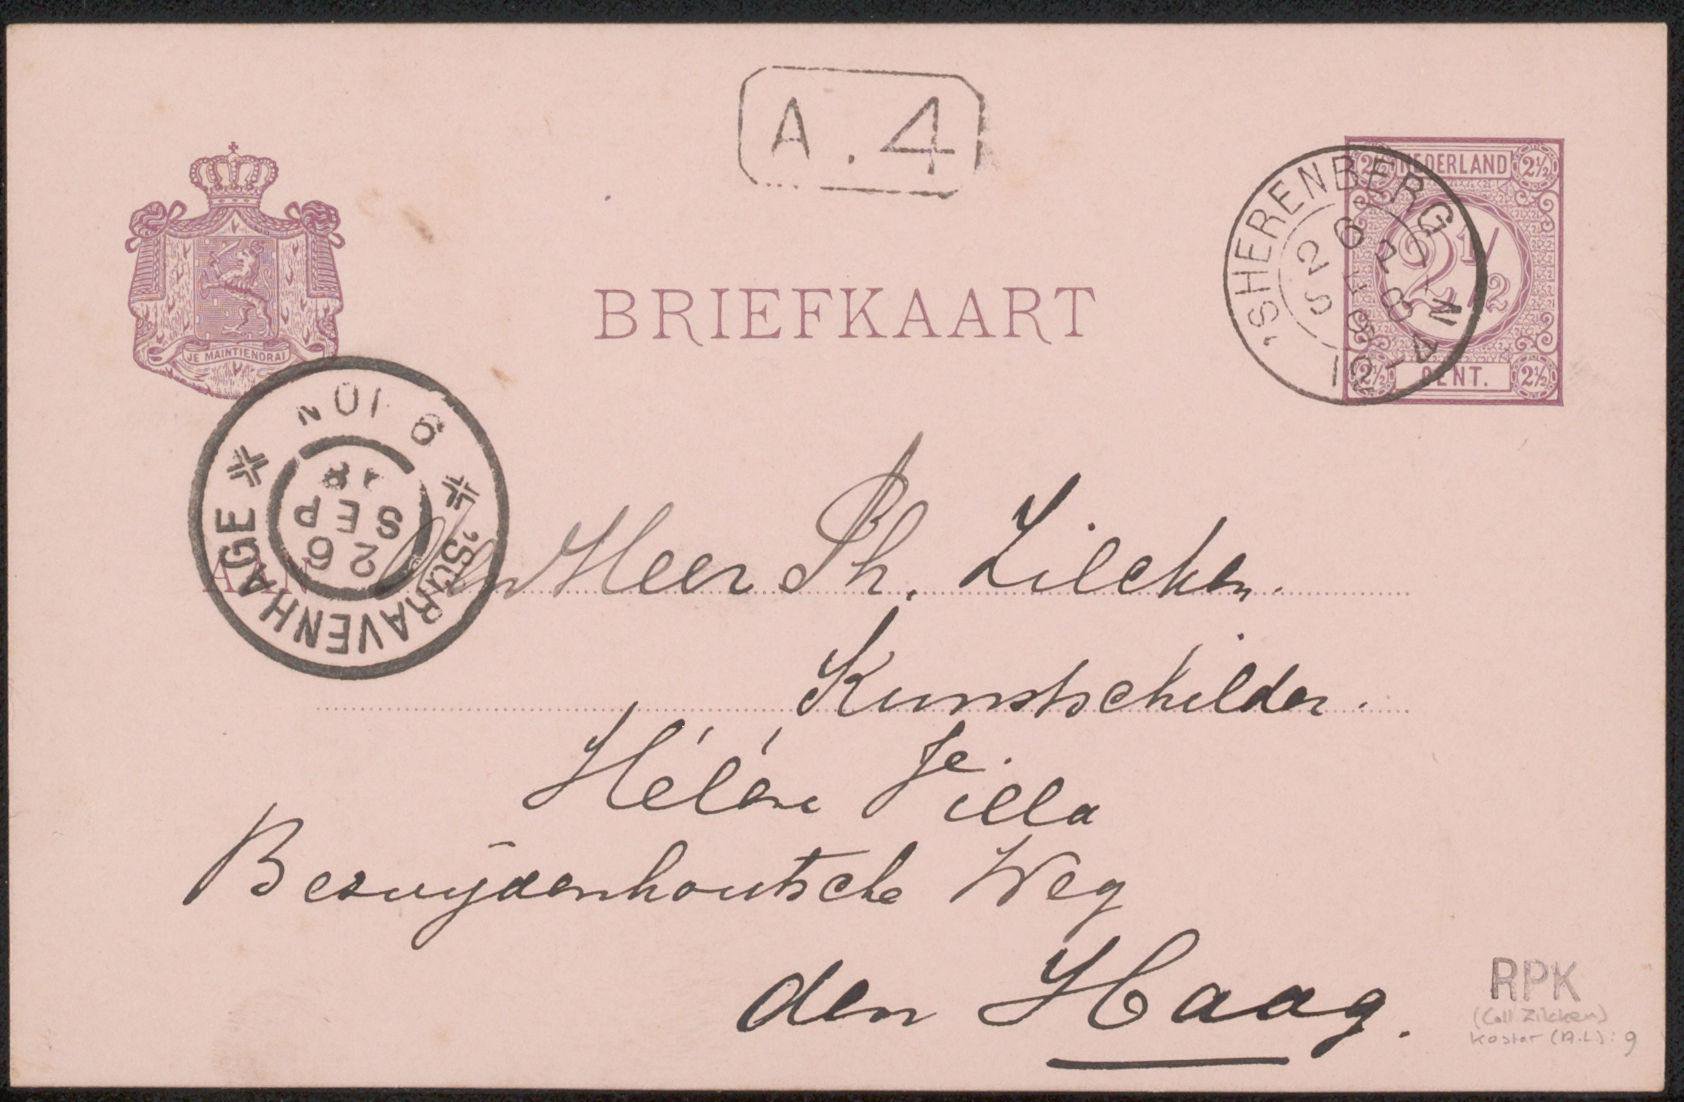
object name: postcard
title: Briefkaart aan Philip Zilcken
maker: anton l. koster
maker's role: draughtsman, painter, print maker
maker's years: 1859-1937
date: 1898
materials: cardboard, ink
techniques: pen, writing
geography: s-heerenberg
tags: the hague, painter, draughtsman, jan hoynck van papendrecht, philip zilcken, literature ~ arts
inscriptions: collector's mark: ‘RPK’